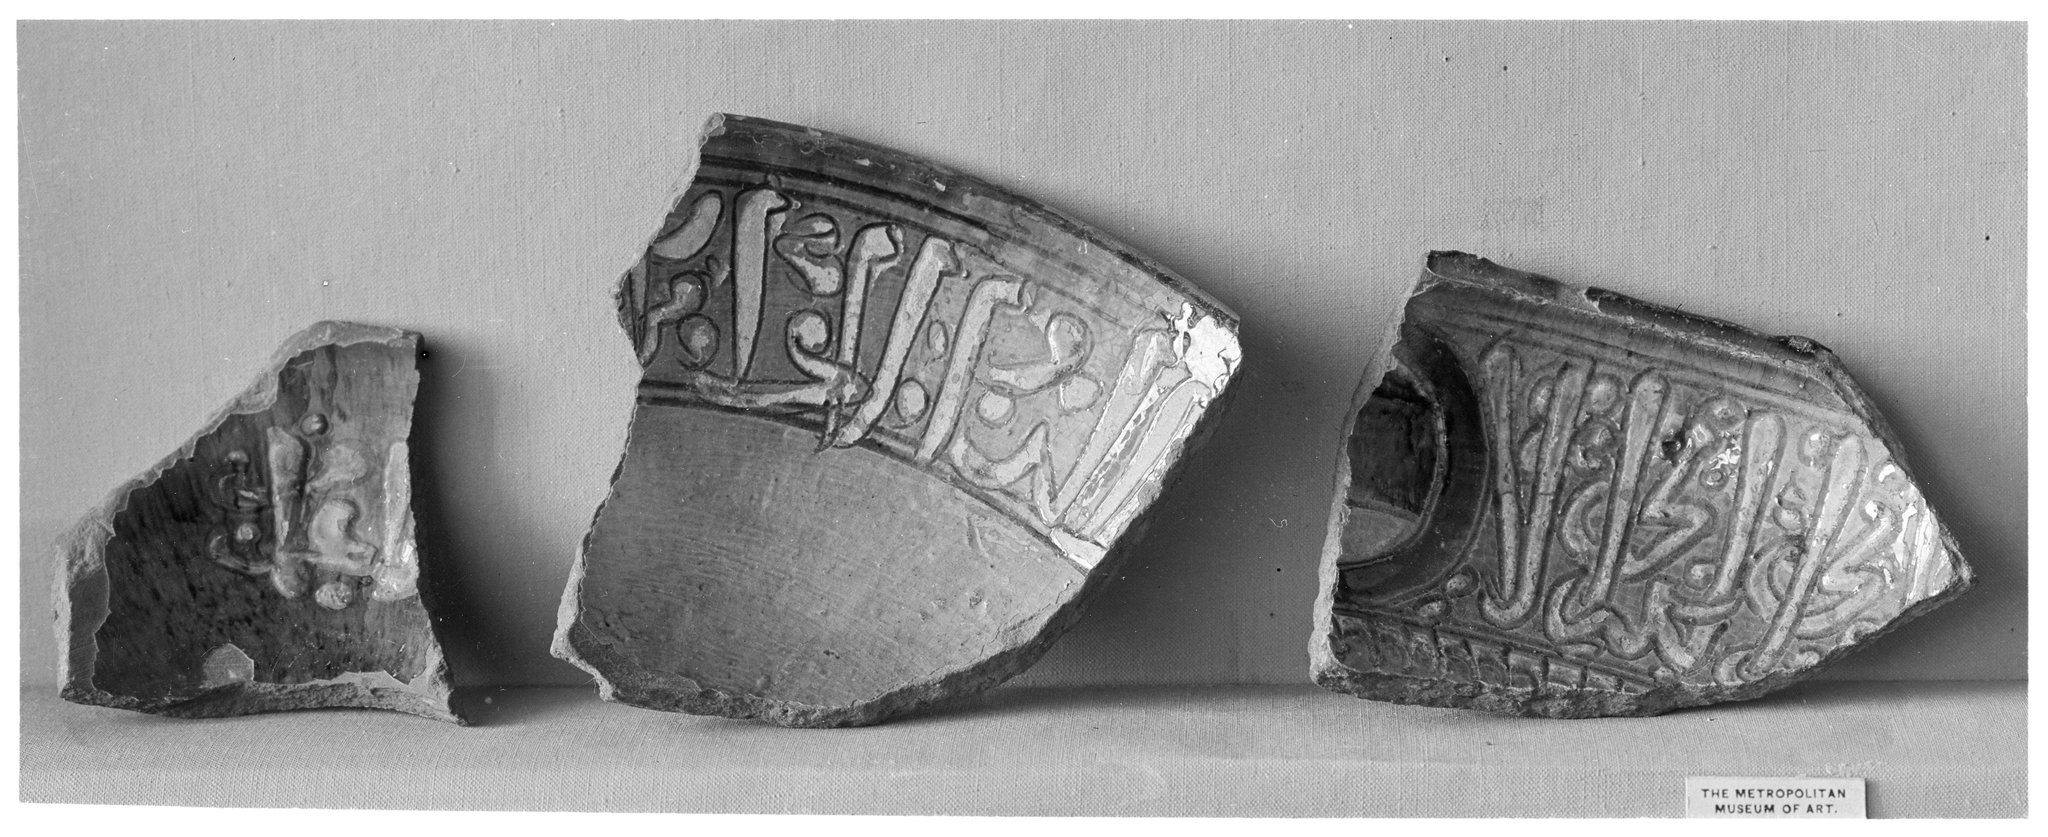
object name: fragment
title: Fragment of a Bowl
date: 1301-1500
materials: earthenware, glaze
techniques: coloring, incising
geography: egypt